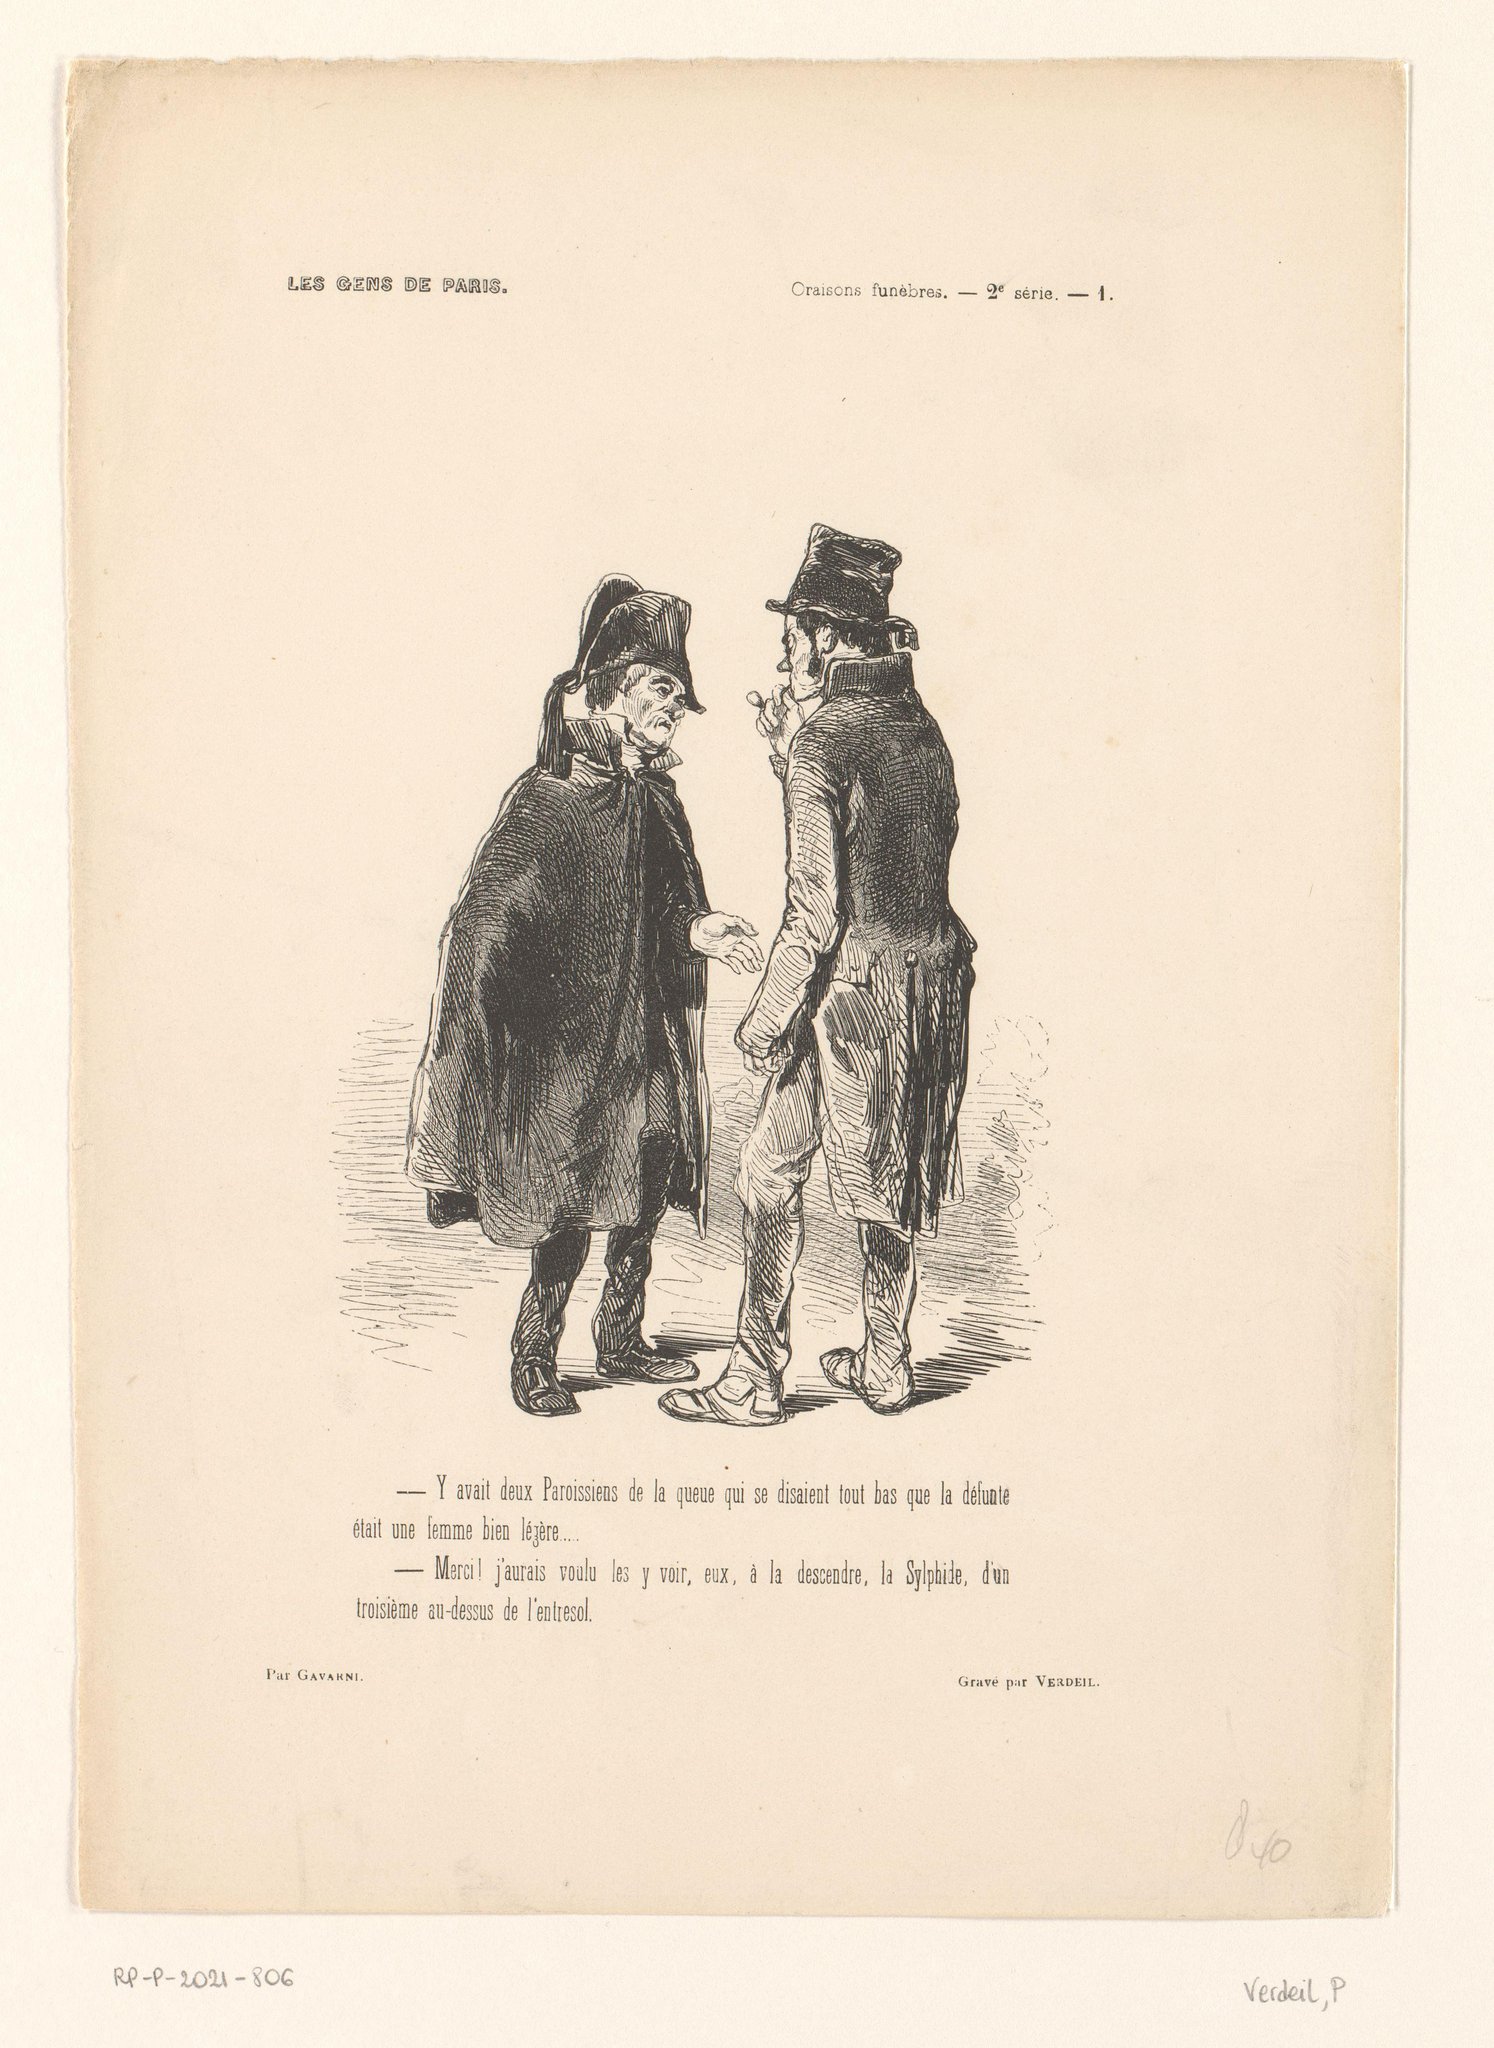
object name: print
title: Twee mannen in gesprek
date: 1846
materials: paper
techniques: letterpress printing, engraving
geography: france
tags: head-gear: hat, conversation, dialogue; conversation piece, coat, cape, paris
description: Prent waarschijnlijk uit: Sand, George. Le diable à Paris: Paris et les Parisiens (...). Parijs: J. Hetzel, 1846.